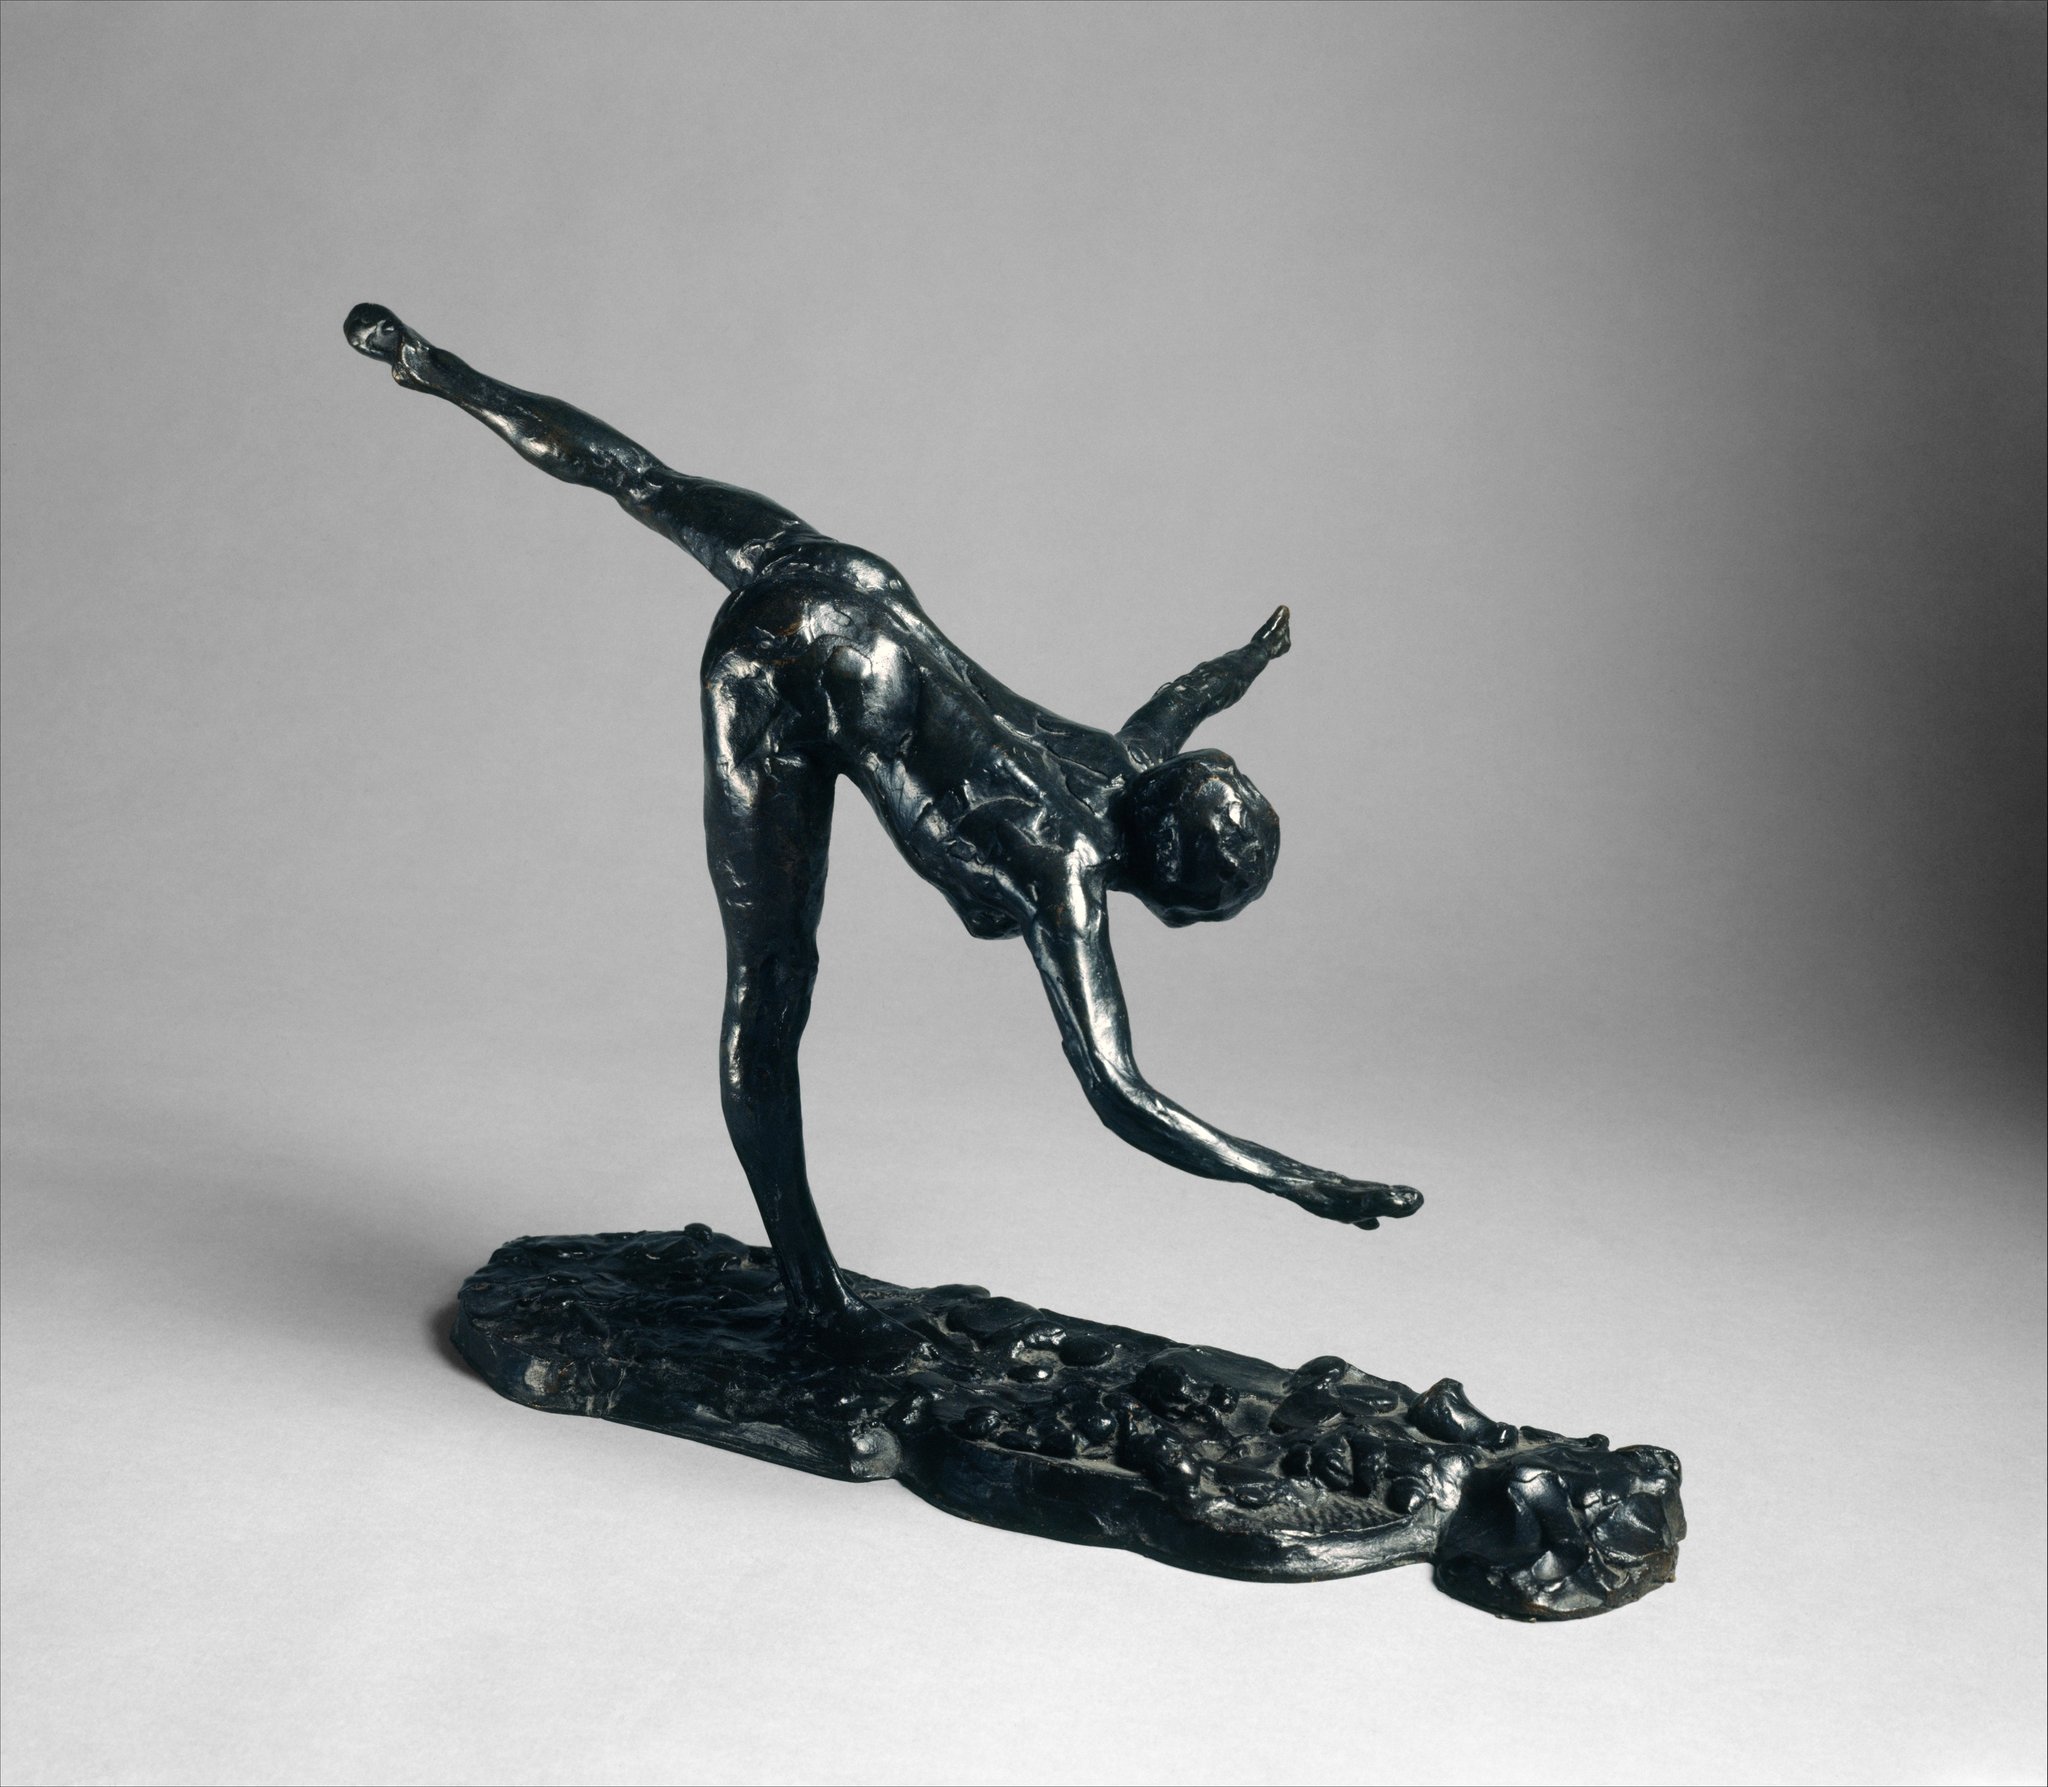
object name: statuette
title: First Arabesque Penchée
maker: edgar degas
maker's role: artist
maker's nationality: french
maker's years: 1834-1917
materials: bronze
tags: female nudes,dancers,ballet